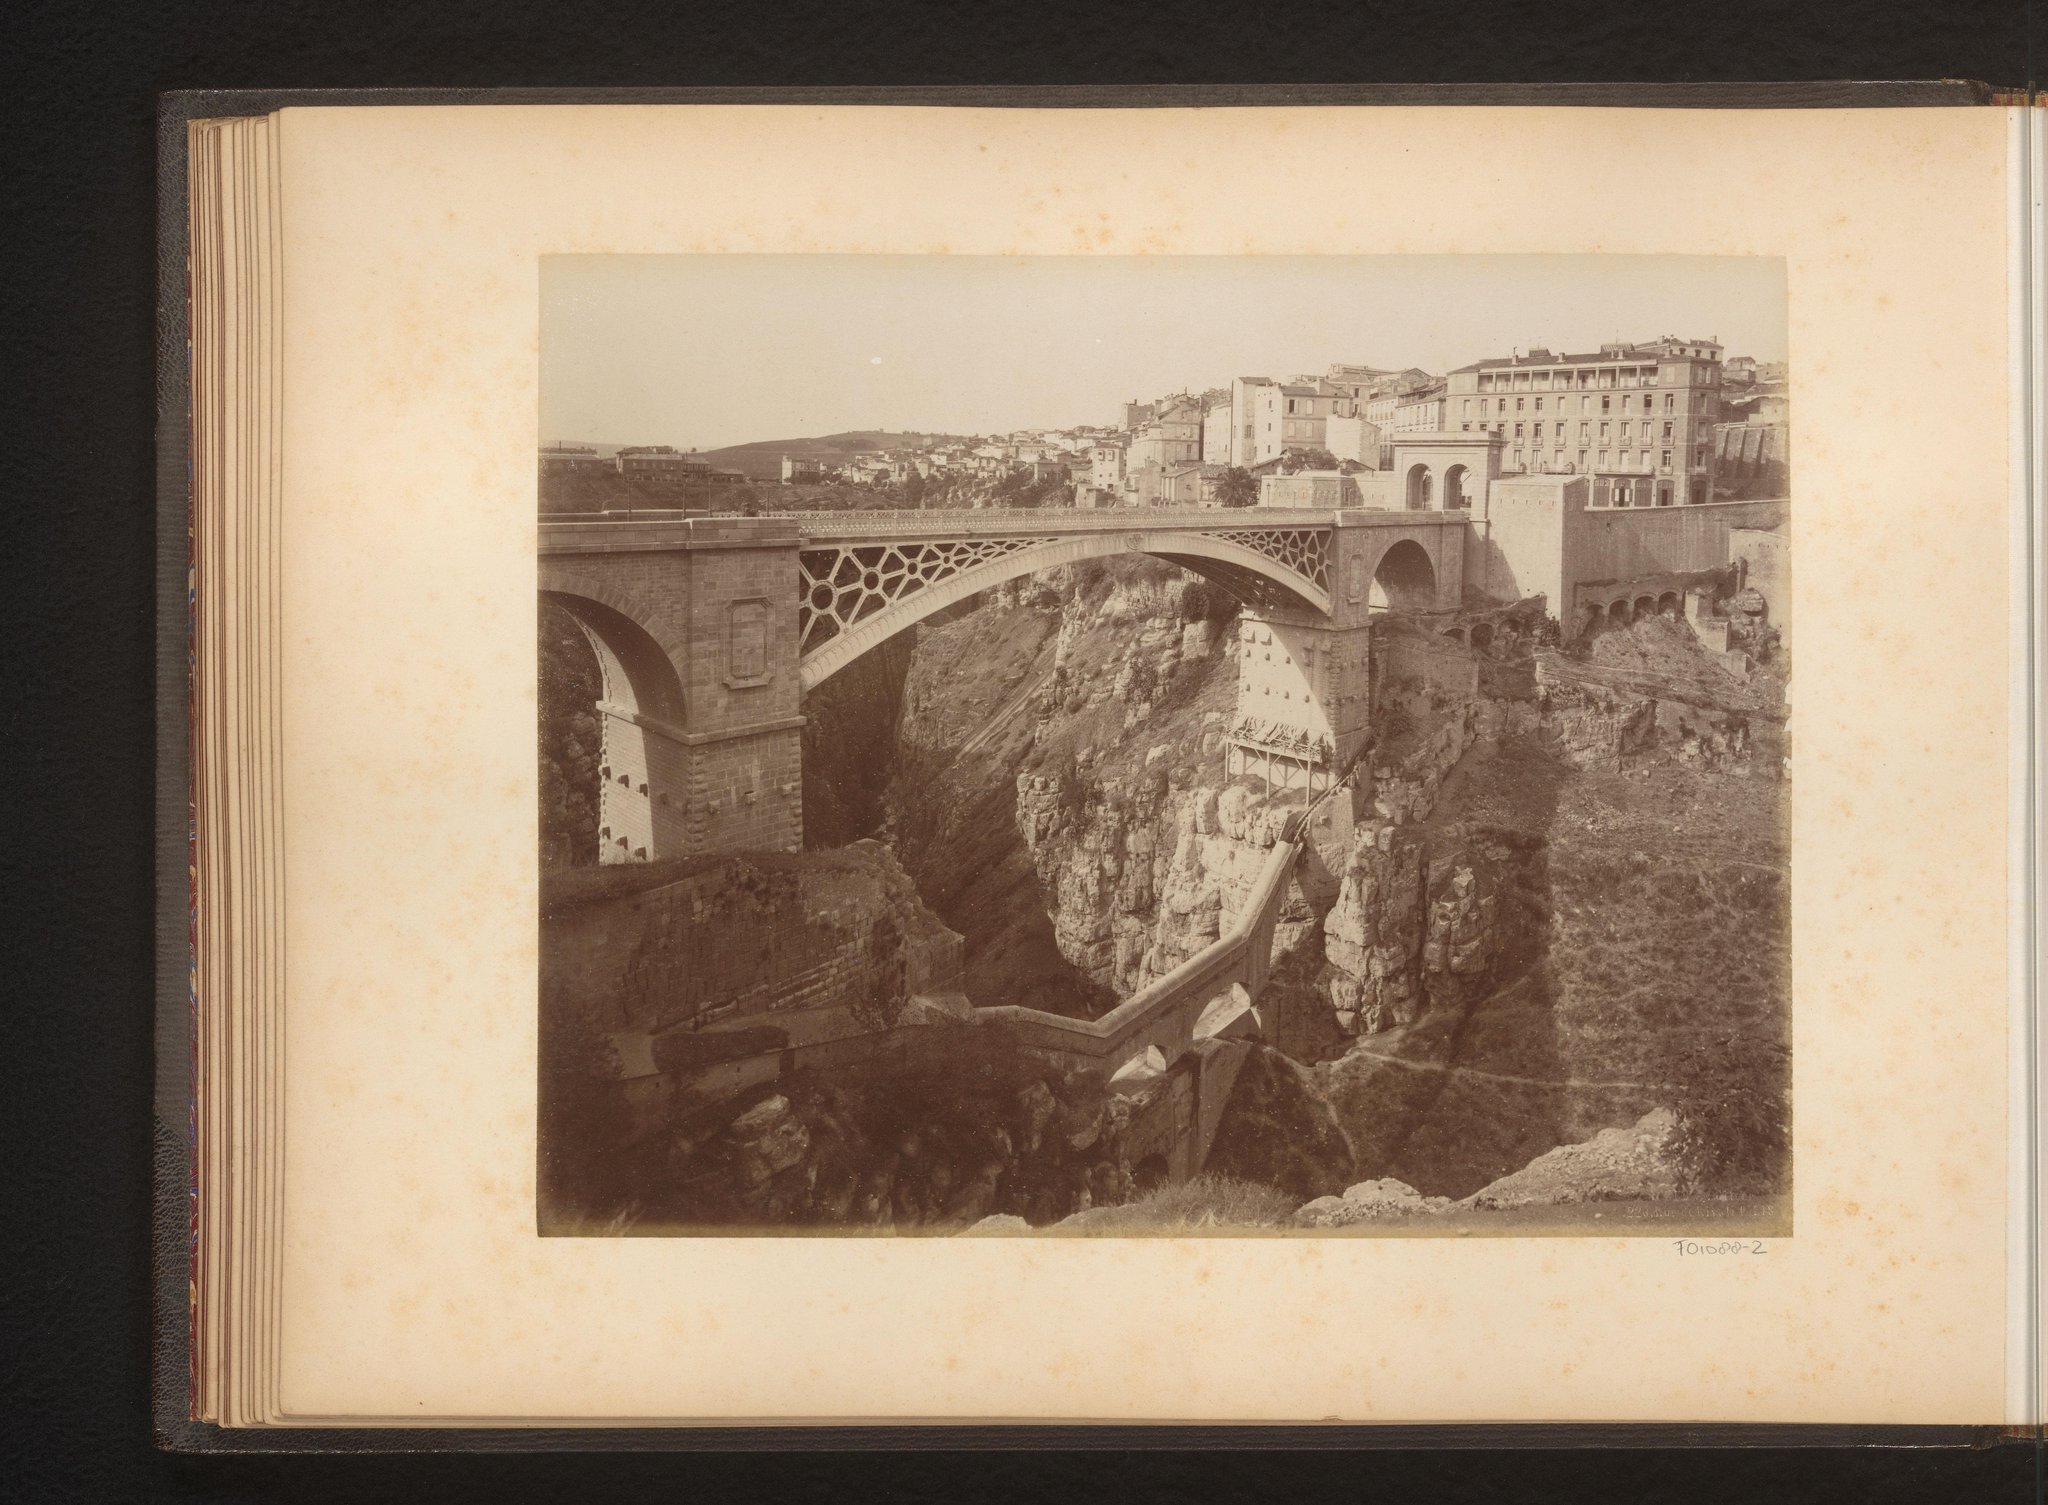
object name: album leaf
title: El Kantara van Constantine en het ravijn van de Rhummel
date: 1875-1885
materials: photographic support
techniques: albumen print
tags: city-view, and landscape with man-made constructions, ravine, chasm, abyss, canyon, bridge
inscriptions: check stamp: ‘J. Kuhn Editeur/ 220 Rue de Rivoli Paris’